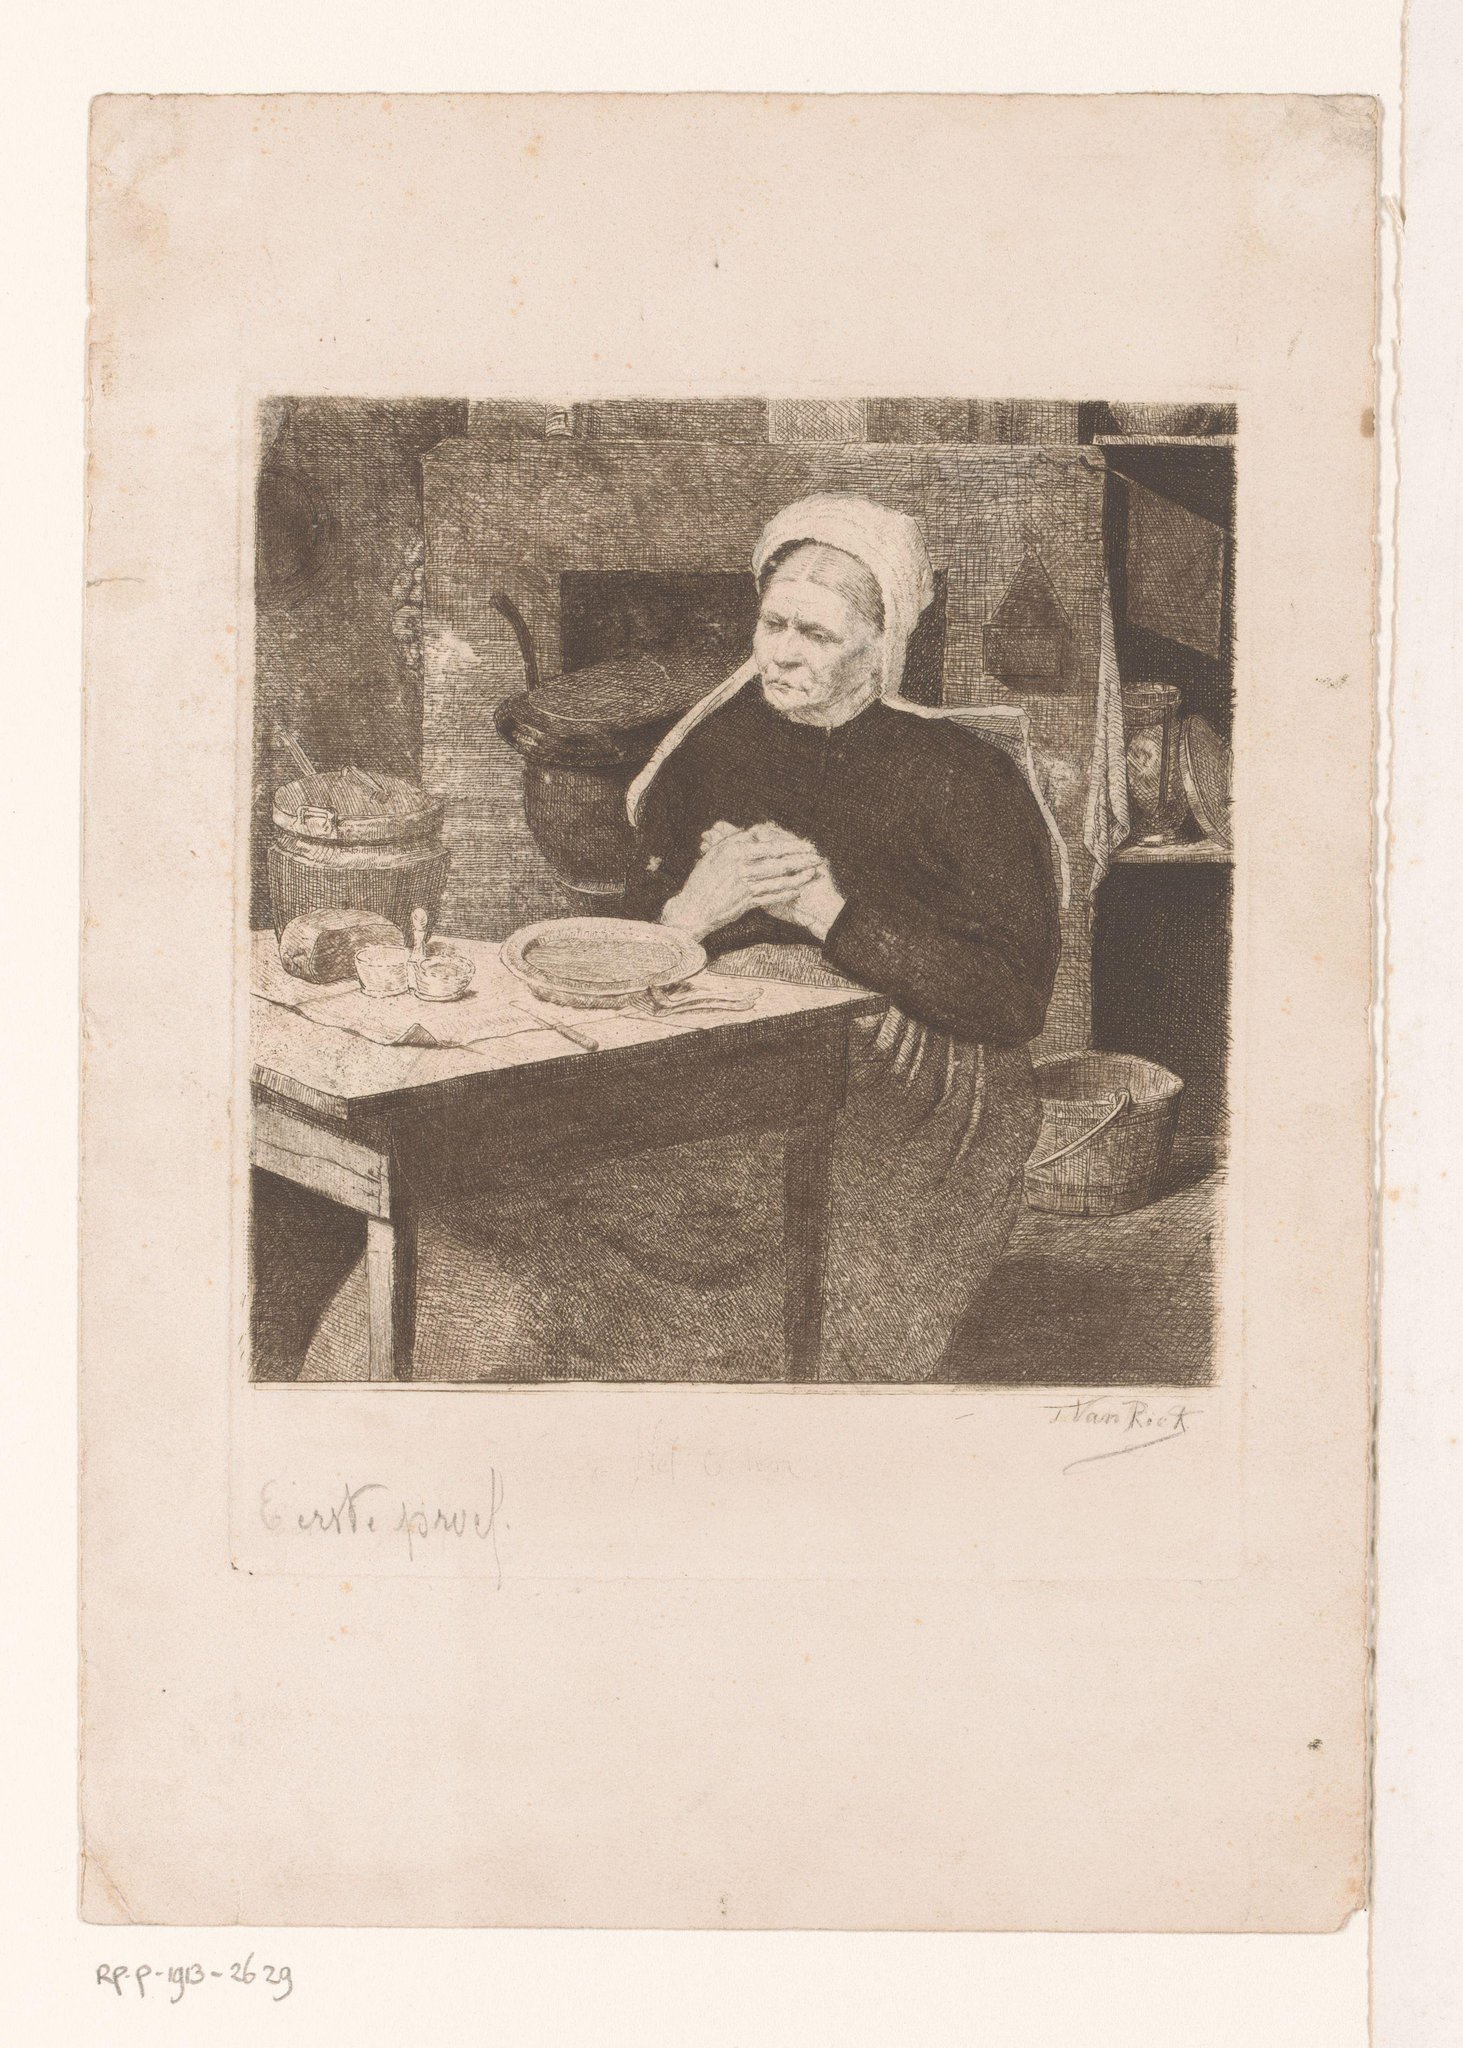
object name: print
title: Oude vrouw gezeten aan een gedekte tafel in een keuken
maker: t. van riet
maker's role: print maker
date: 1885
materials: paper, pencil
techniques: etching, intaglio, roulette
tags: old woman, kitchen-interior, laid table: table-ware, table-decoration, etc.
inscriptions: collector's mark: Lugt 2228